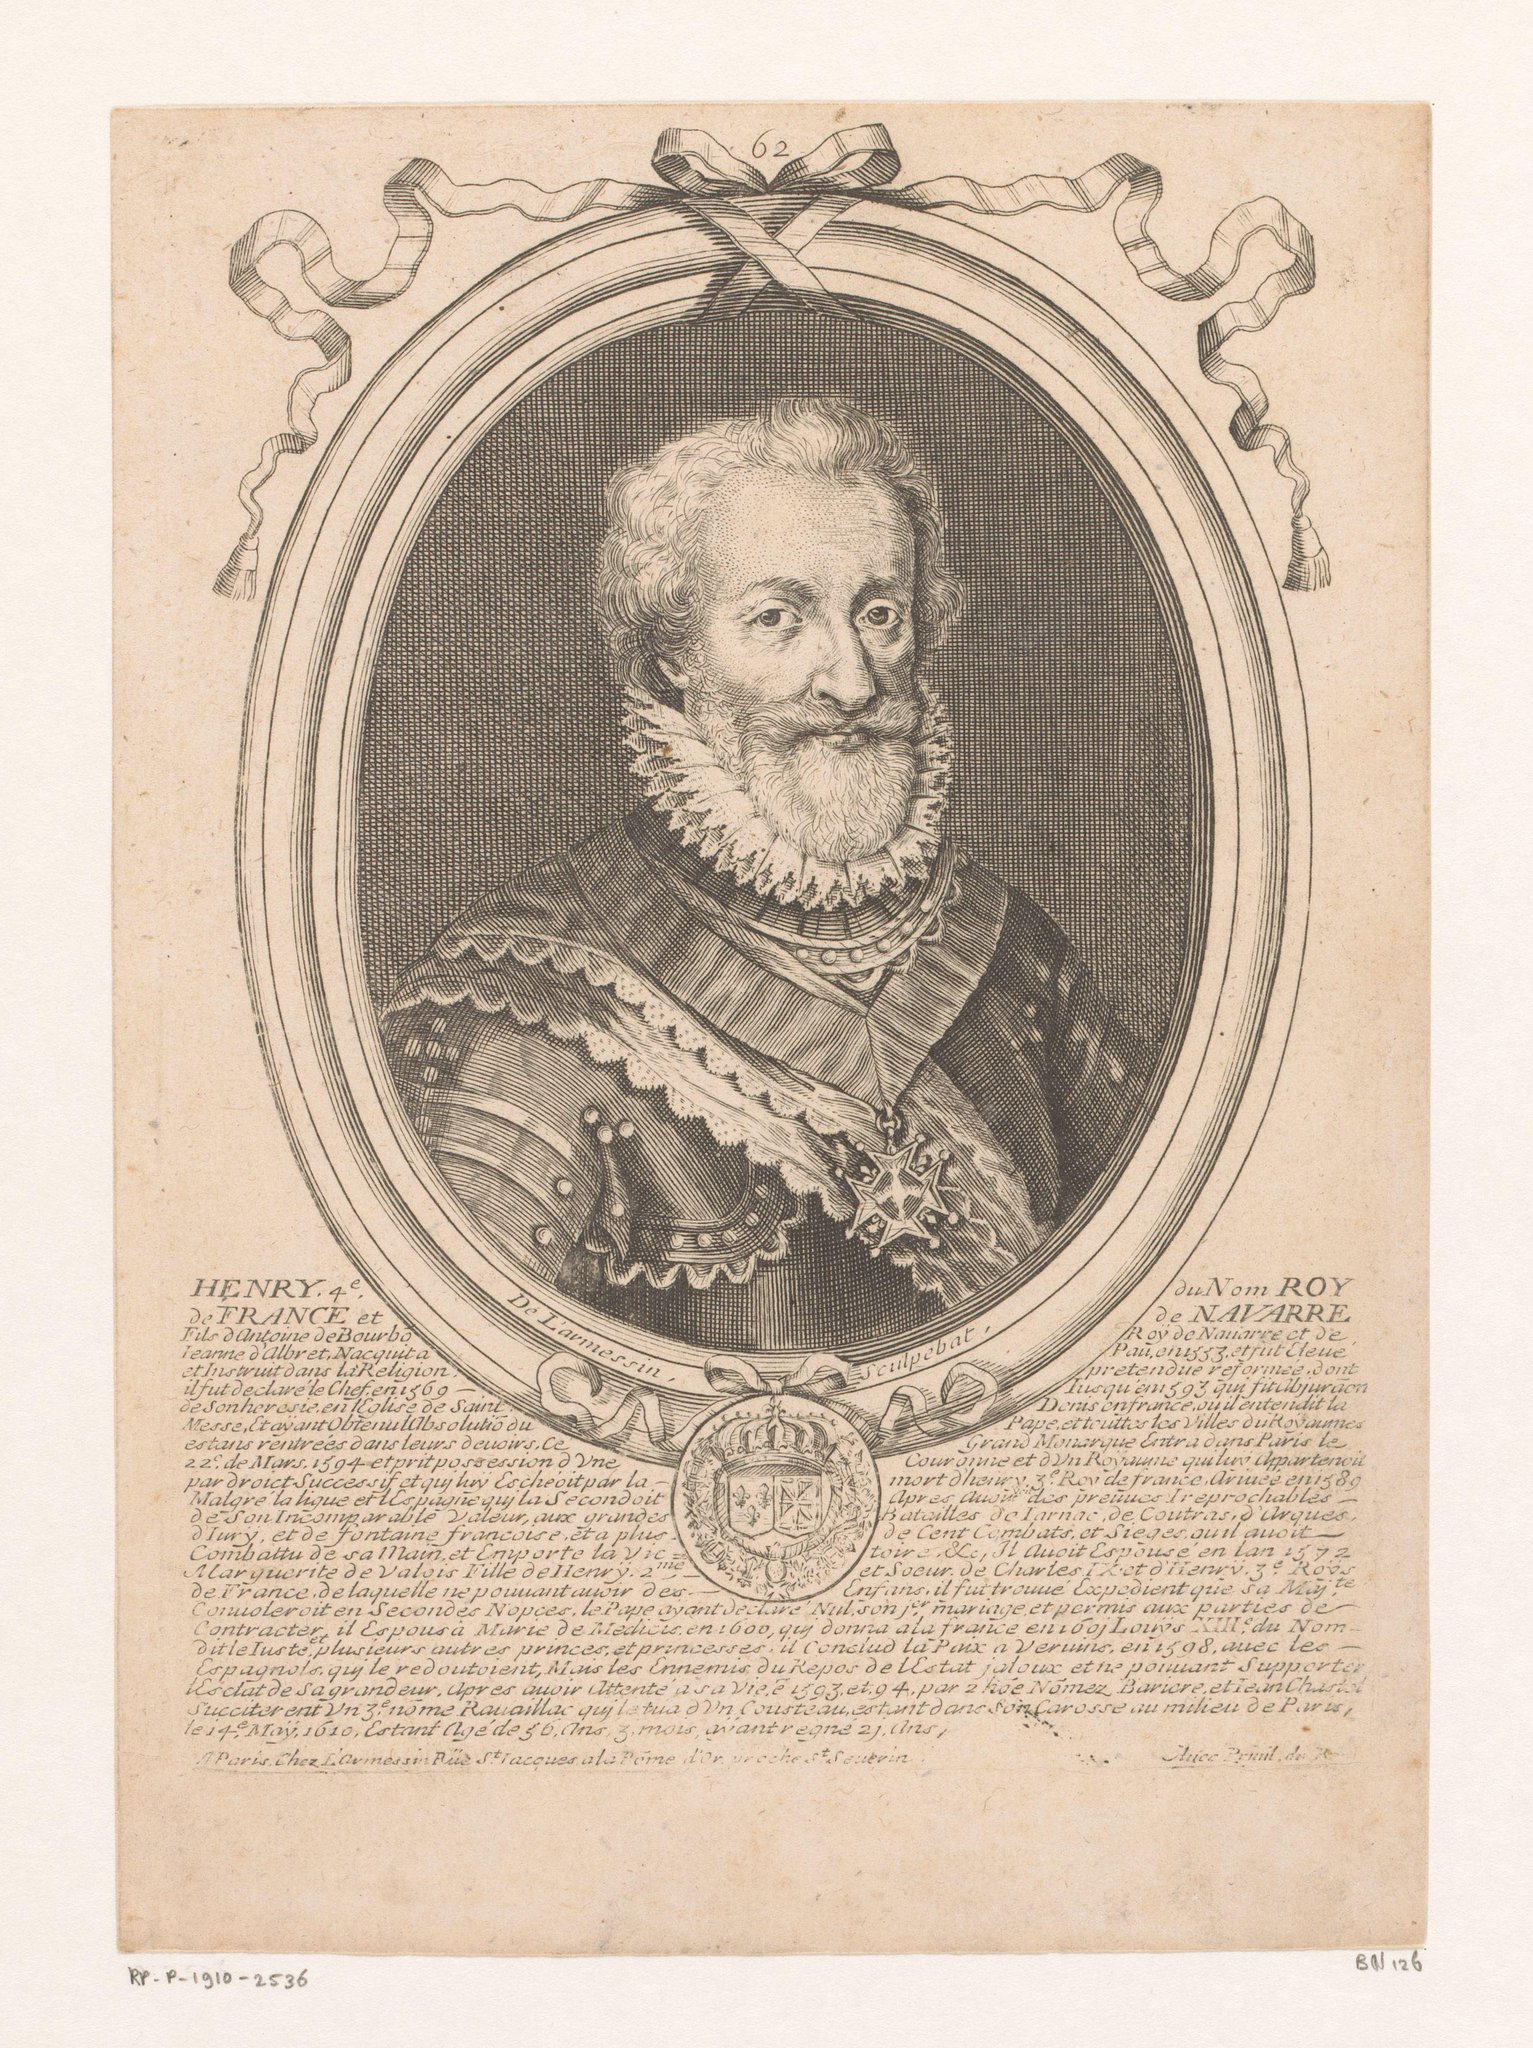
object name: print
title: Henry 4e du Nom Roy de France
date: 1642-1694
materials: paper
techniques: engraving, etching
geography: paris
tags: paris, hendrik iv (koning van frankrijk en navarra), historical persons, king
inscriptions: collector's mark: Lugt 2228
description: Maakt deel uit van een grootschalige serie met portretten van prominente figuren. Binnen de serie bevindt zich een sectie getiteld 'Les Augustes Représentations De tous les Roys De France depuis Pharamond Iusqu'à Louys XIIII'. De serie werd respectievelijk uitgegeven door Pierre Bertrand, door zijn weduwe en door De Larmessin zelf.